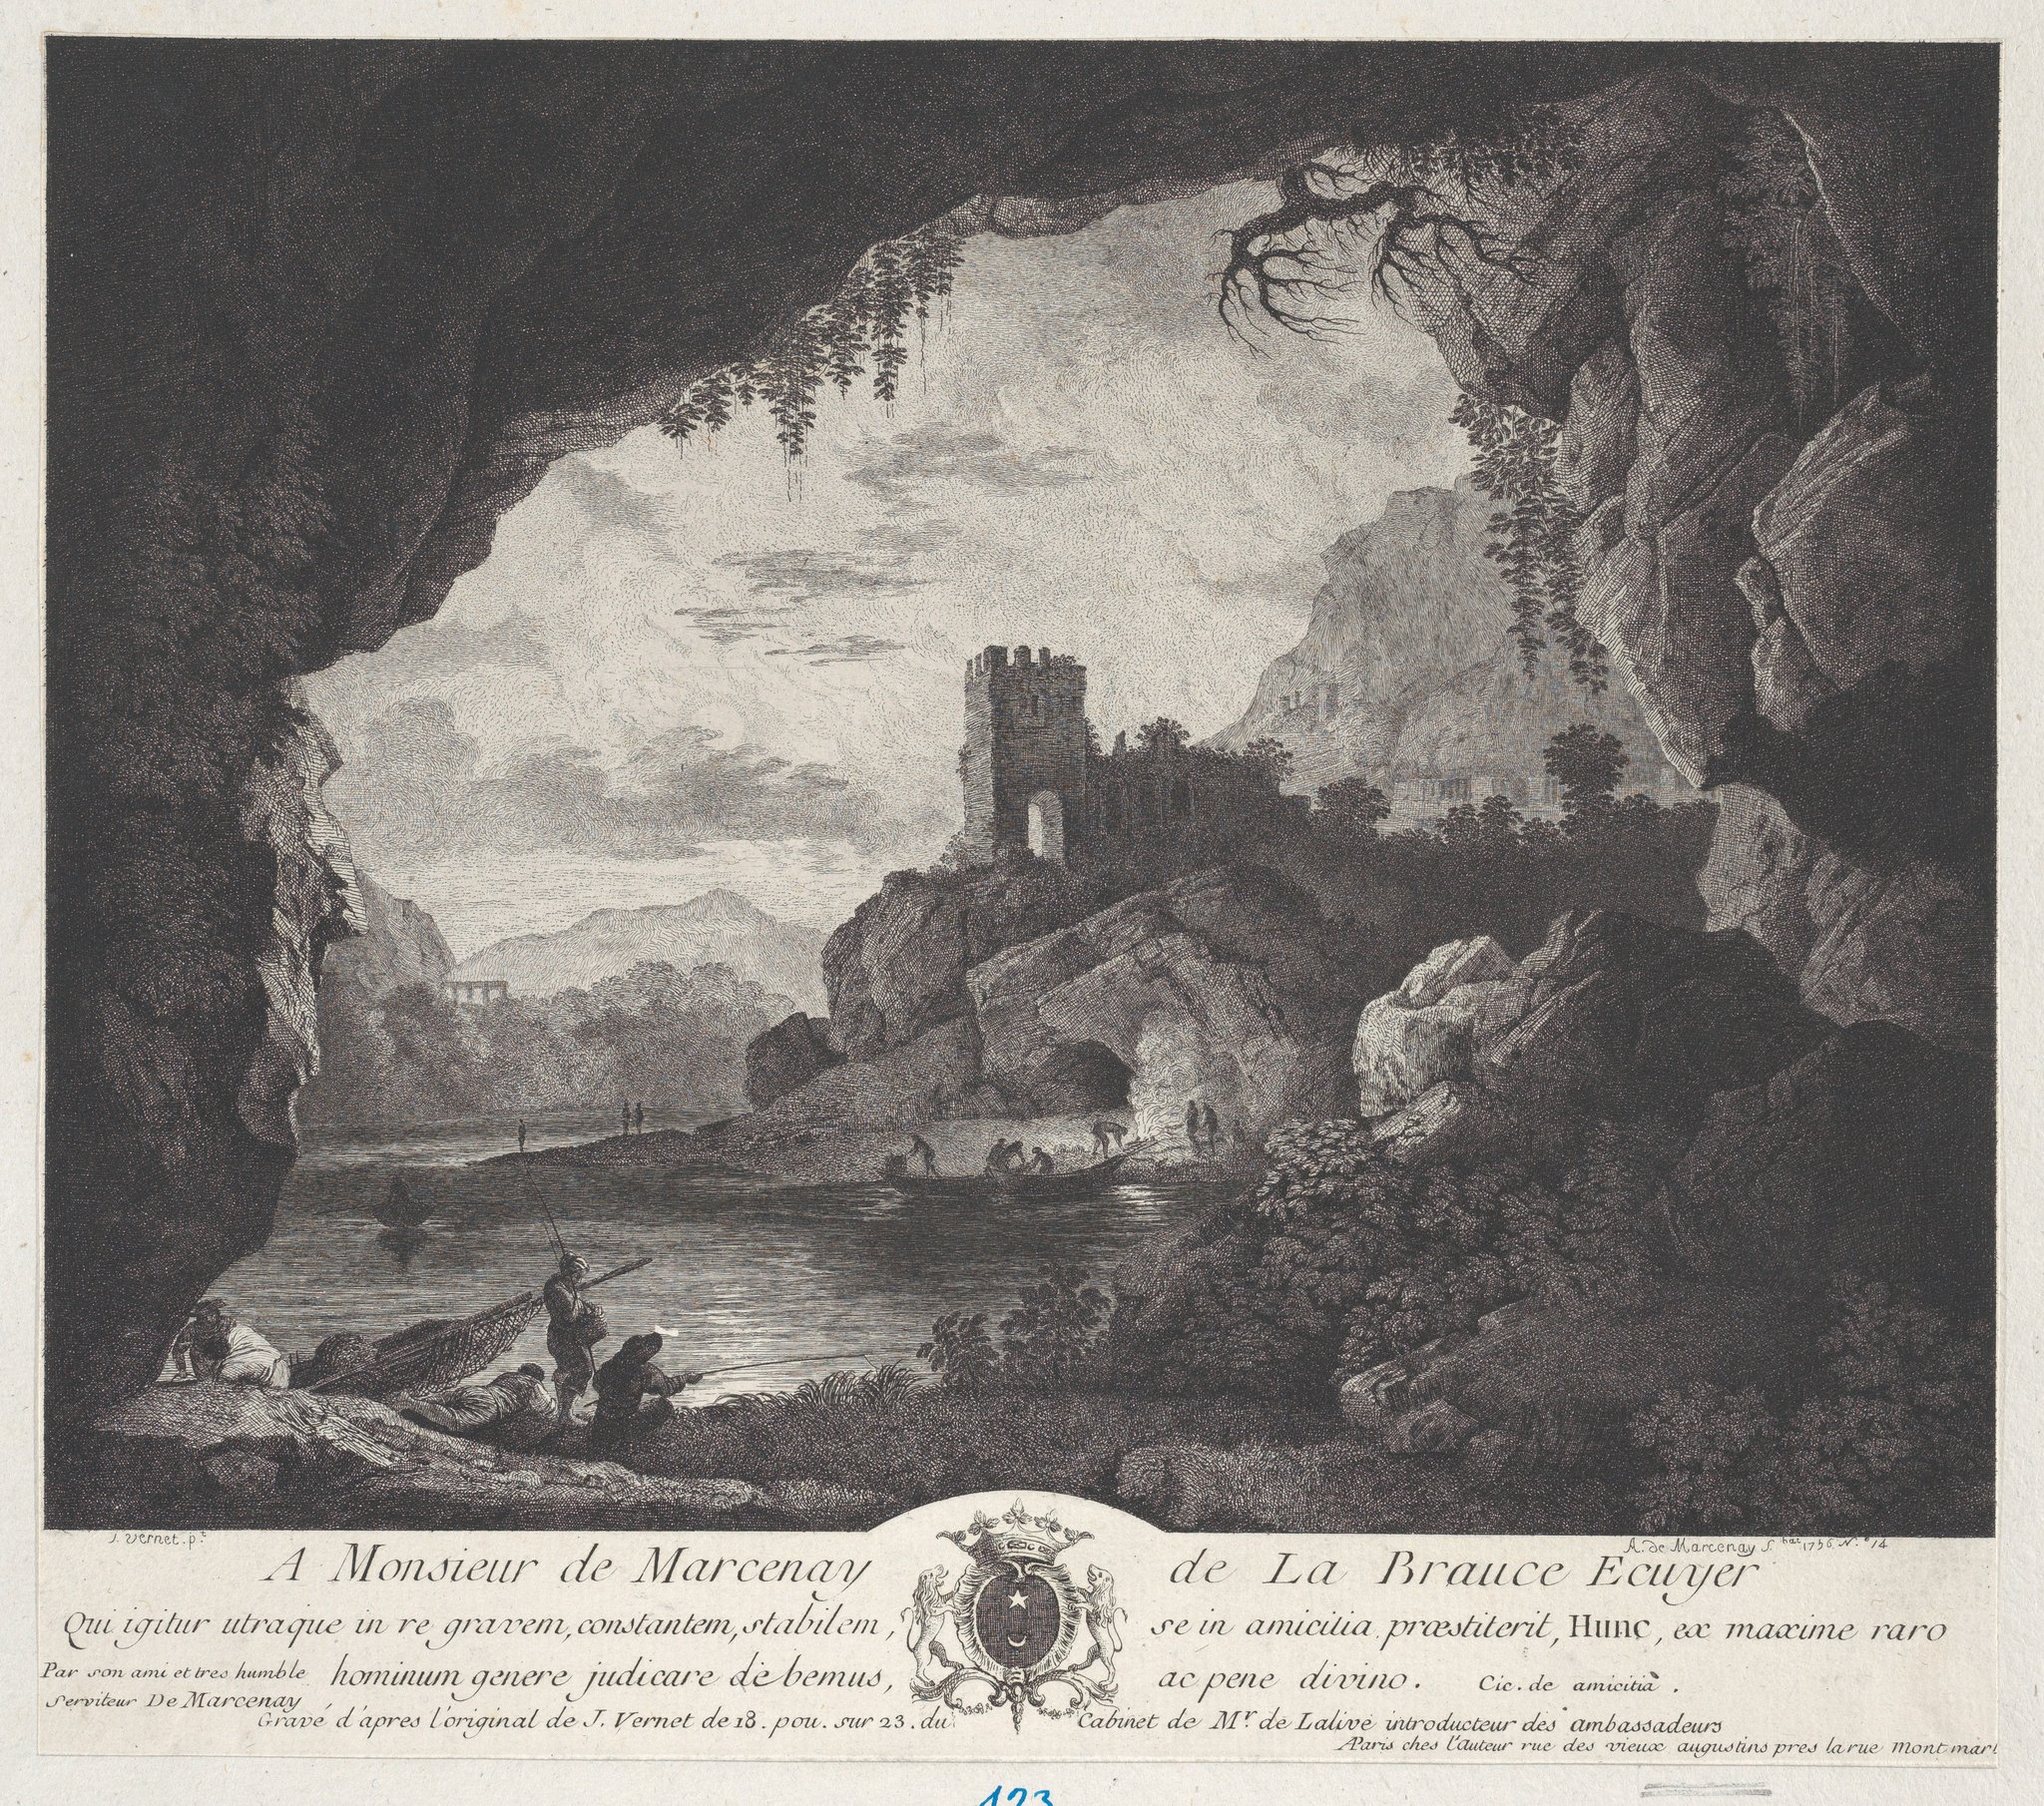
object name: print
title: Landscape from a Cave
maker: joseph vernet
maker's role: artist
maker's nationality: french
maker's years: 1714-1789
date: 1756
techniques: engraving